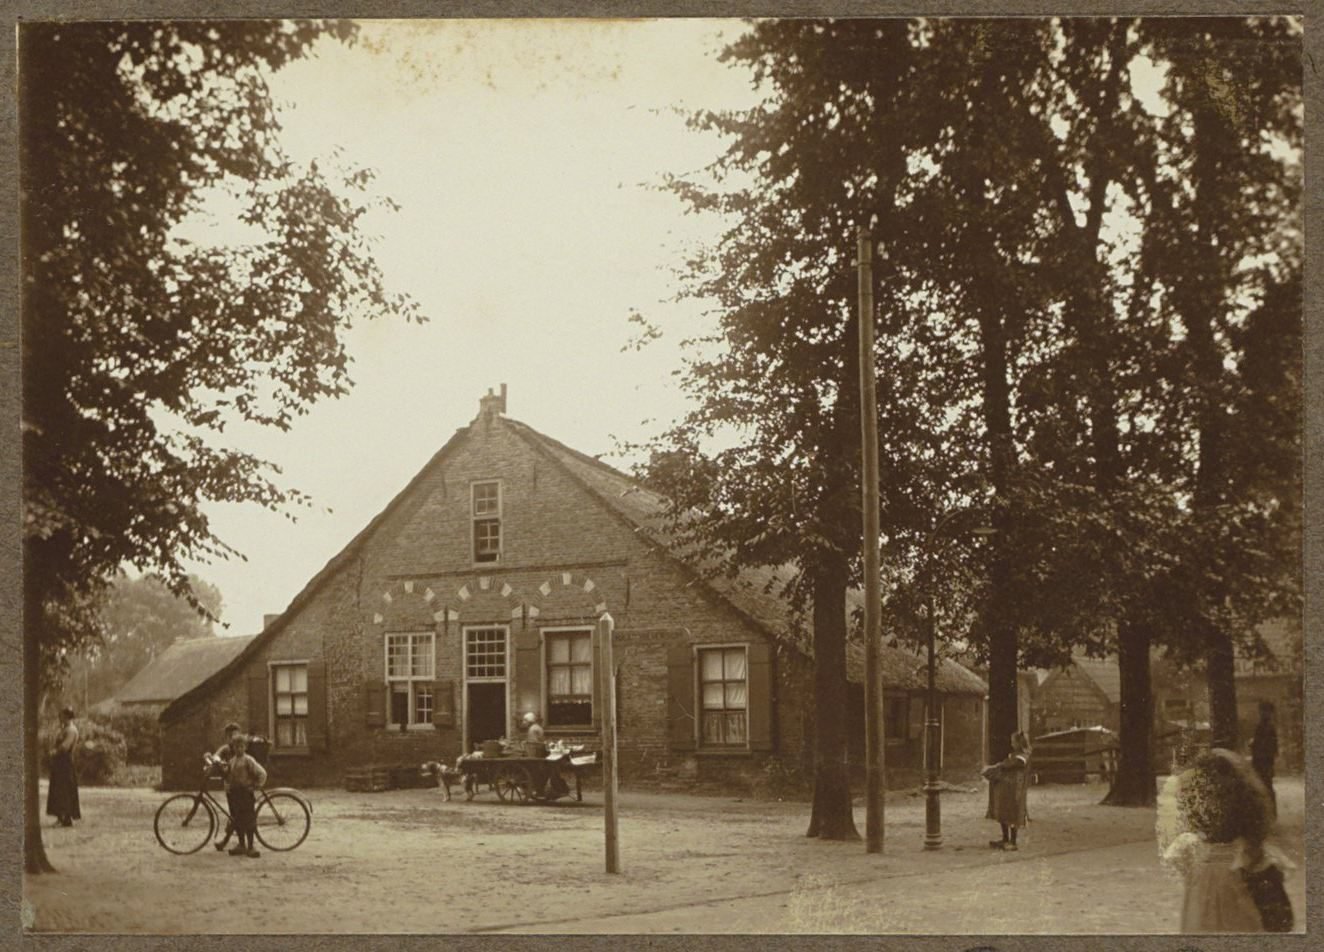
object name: photograph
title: Boerderij in Laren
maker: Anonymous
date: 1910-1930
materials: paper, photographic support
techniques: gelatin silver print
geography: laren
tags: farm or solitary house in landscape, farm (building)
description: Onderdeel van Album met foto's van Amsterdam en omgeving.